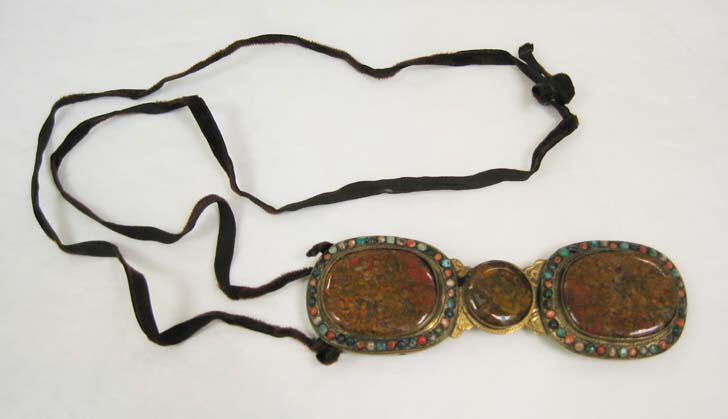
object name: belt buckle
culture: chinese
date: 1735-1796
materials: cotton, metal, stone